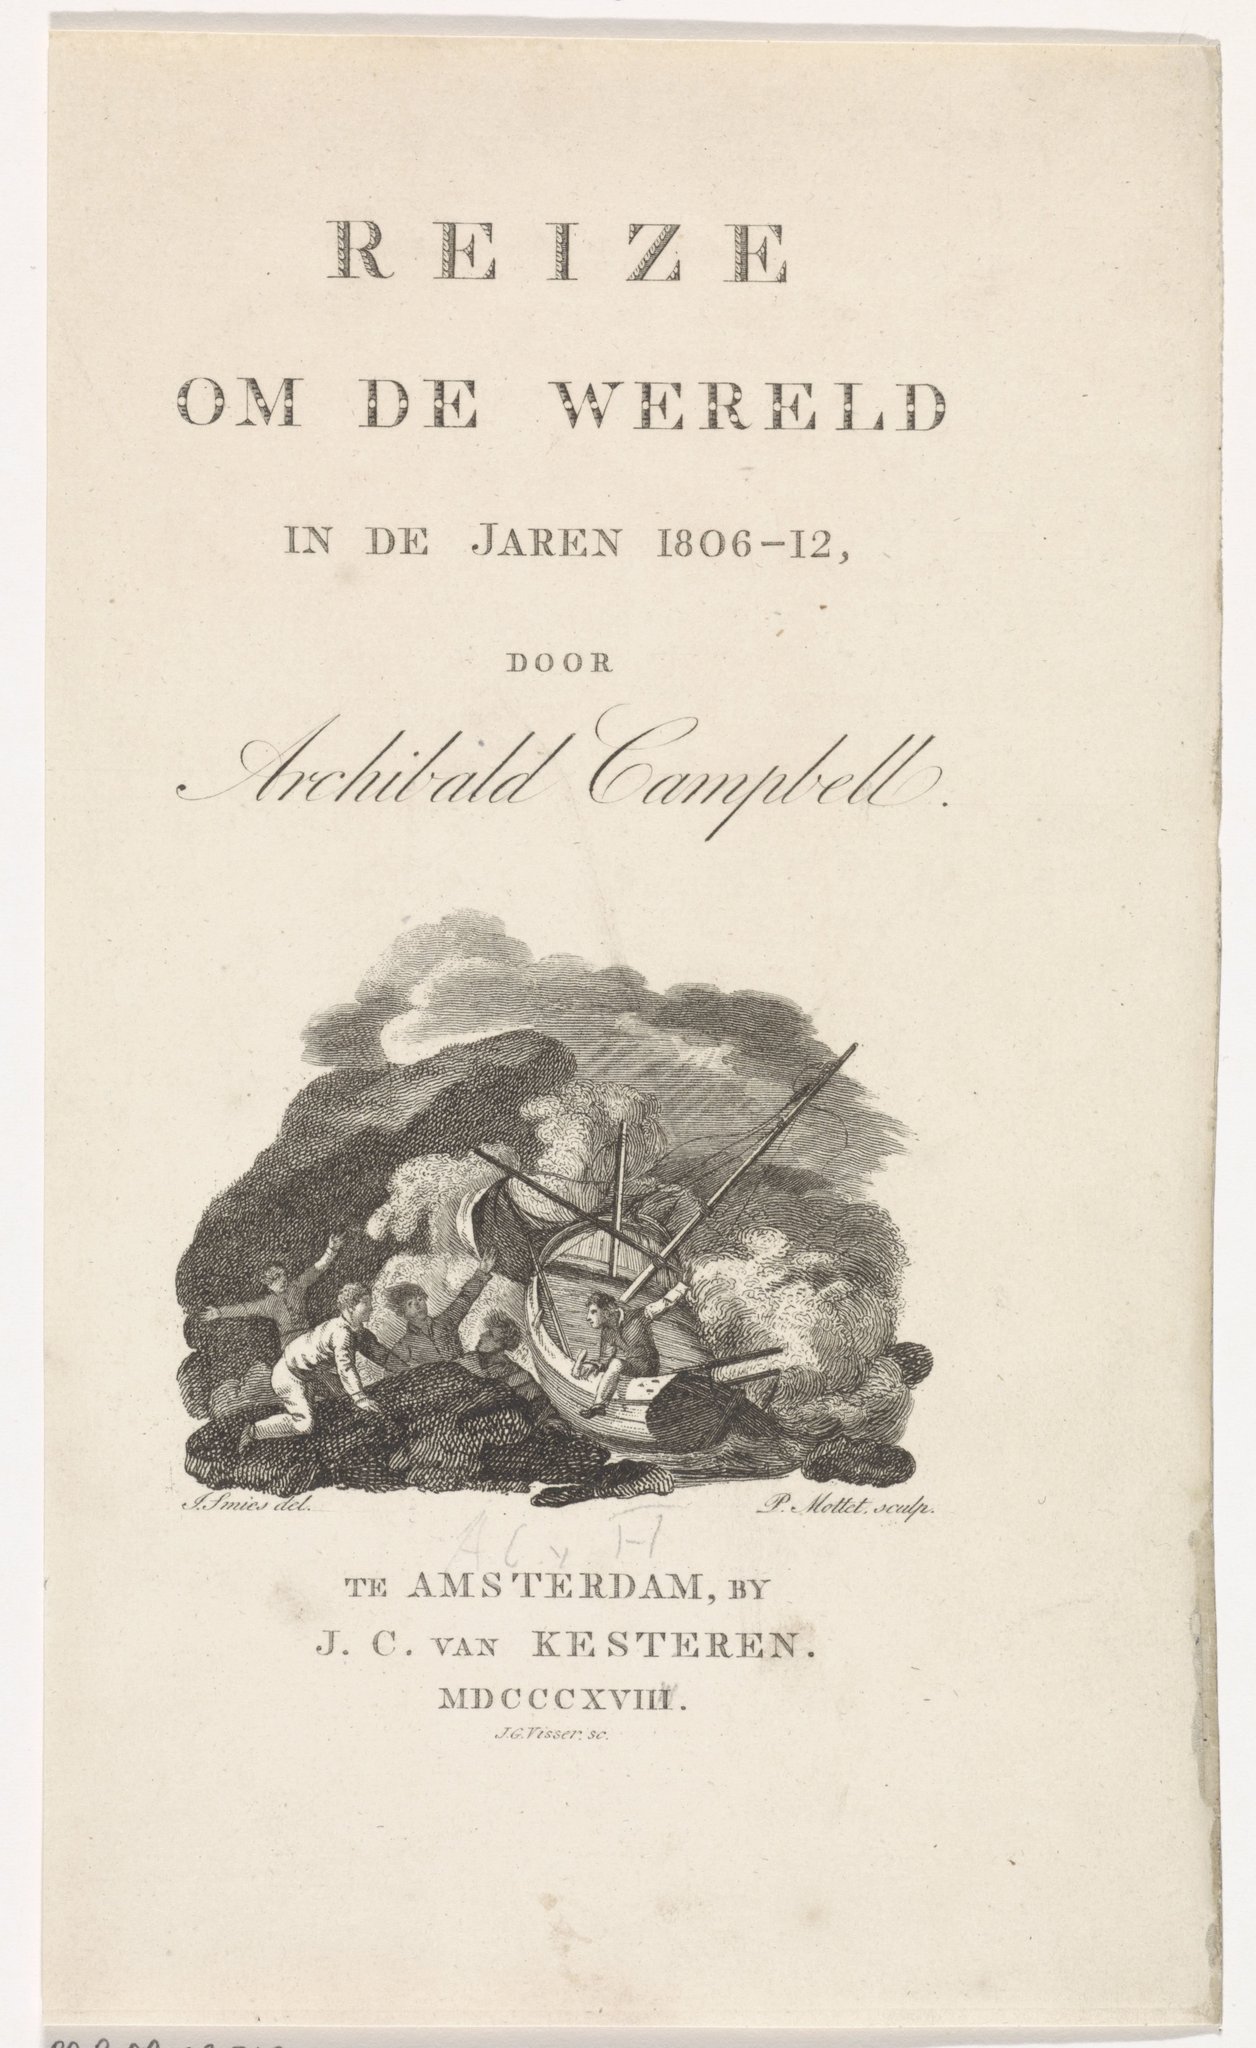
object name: print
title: Titelpagina voor: A. Campbell, Reize om de wereld in de jaren 1806-12, 1818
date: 1818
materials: paper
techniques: etching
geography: amsterdam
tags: shipwreck, rocks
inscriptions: collector's mark: Lugt 2228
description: Titelpagina voor: Campbell, Archibald. Reize om de wereld, in de jaren 1806-12. Amsterdam: Johannes Christoffel van Kesteren, 1818.